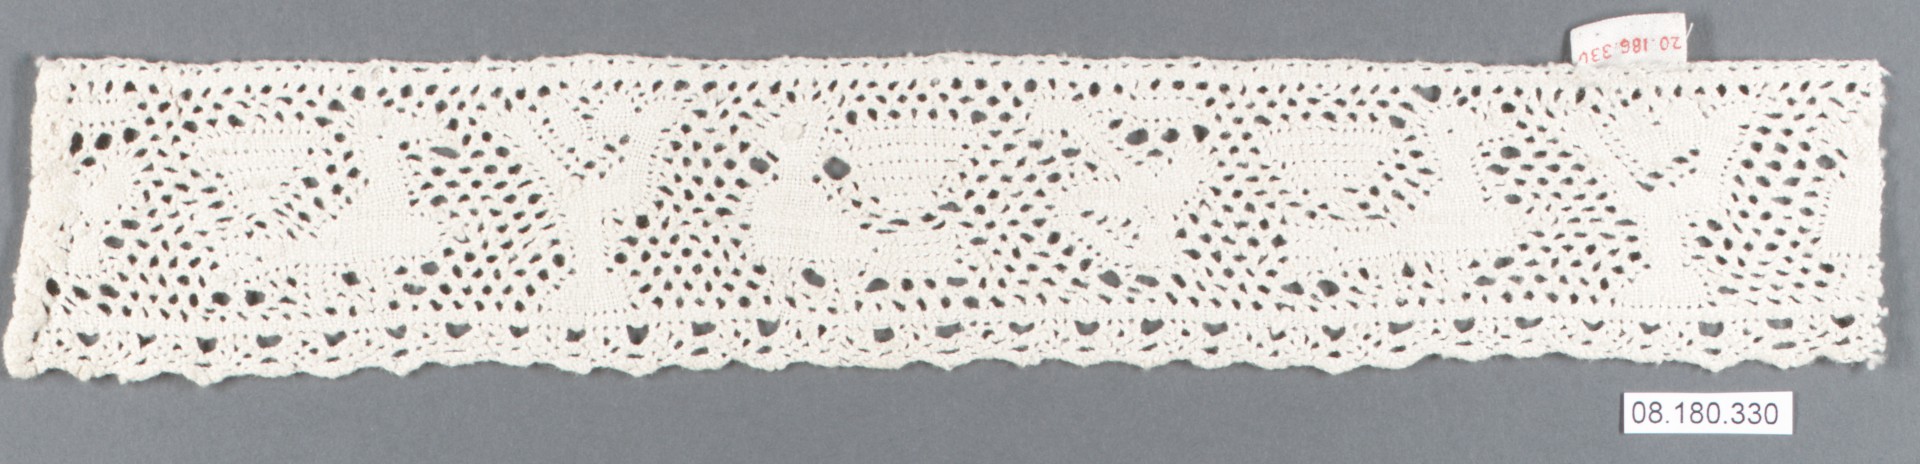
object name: edging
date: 1701-1800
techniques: lace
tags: animals,birds